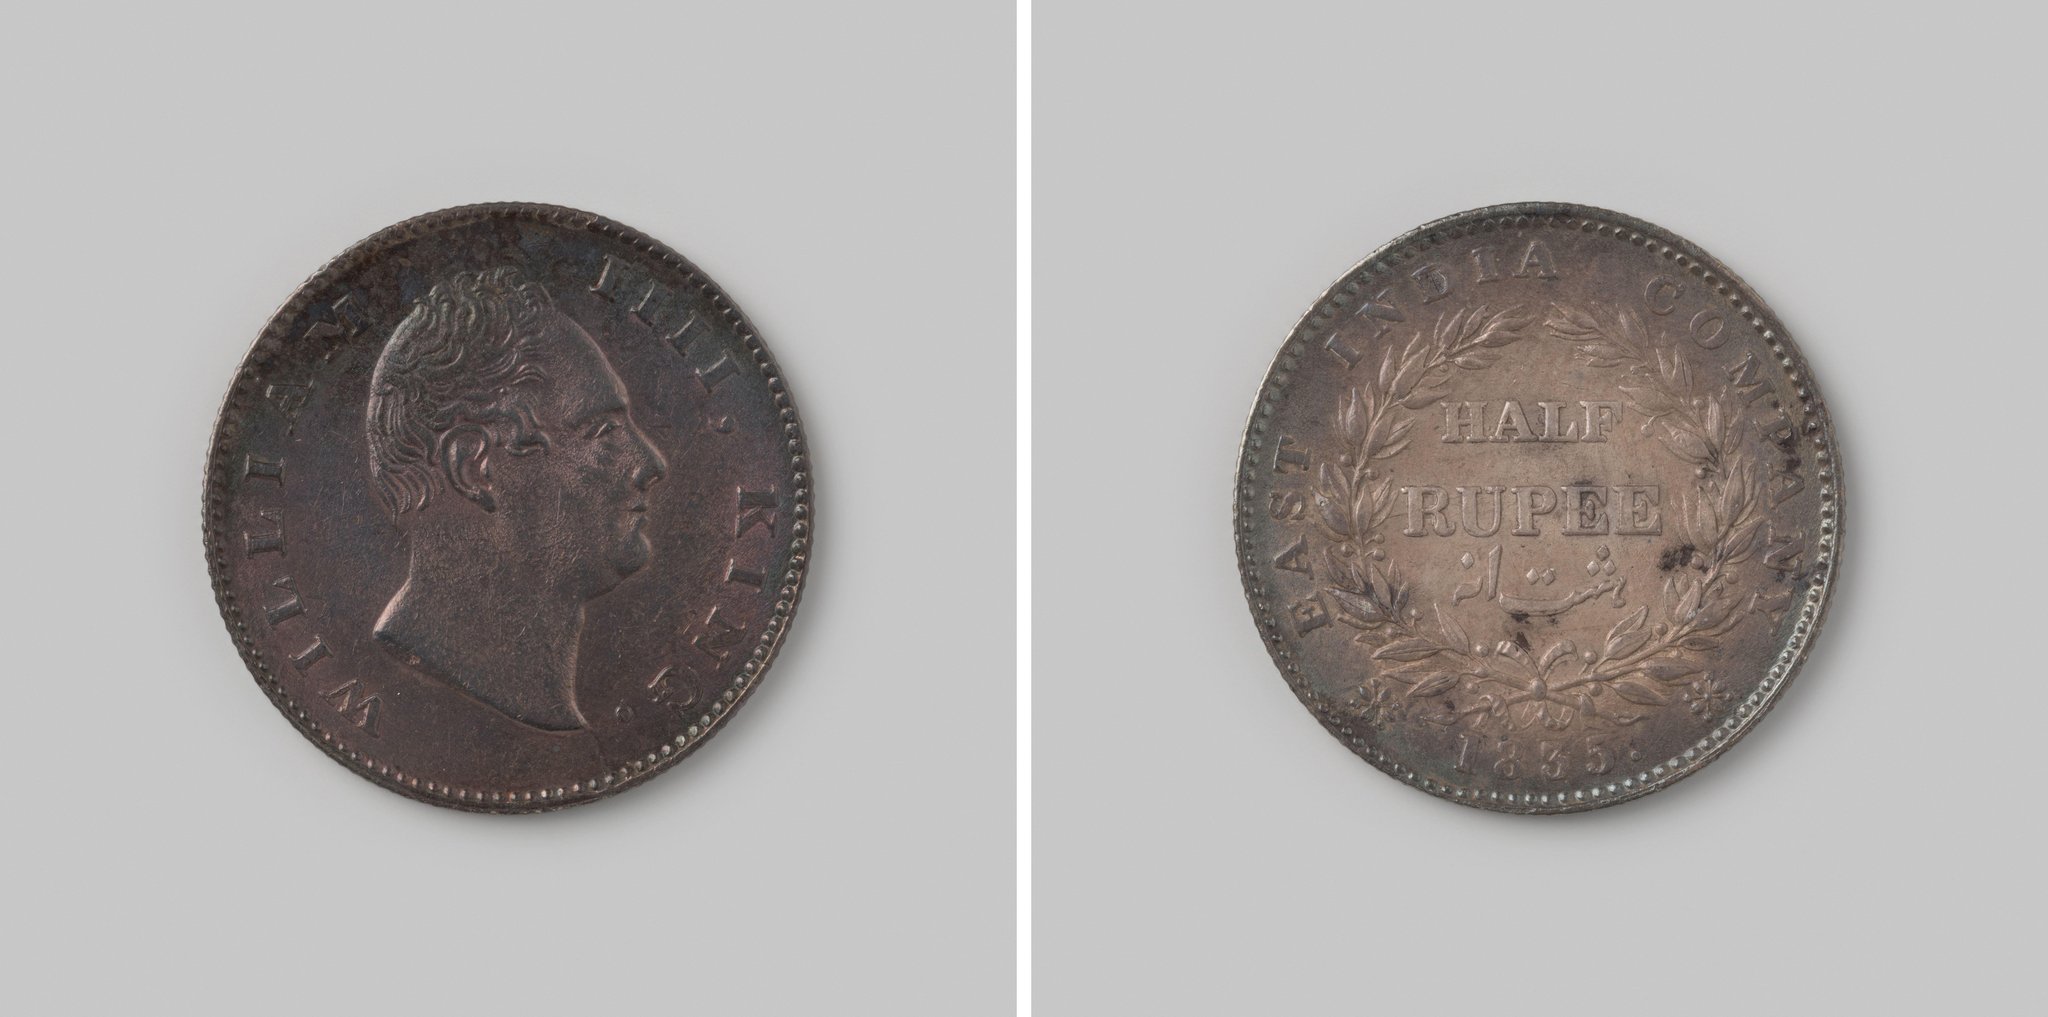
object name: coin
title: India, Engelse Oostindische Compagnie (EIC), op naam van koning William IV, ½ roepie, 1835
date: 1835-1840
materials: silver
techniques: striking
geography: kolkata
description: Zilveren munt. Voorzijde: hoofd van koning William IV naar rechts. Op halsafsnede inwendige letter F [= Forbes, muntmeester te Calcutta]. Keerzijde: tussen twee samengebonden takken in twee regels waarde-aanduiding: half rupee, waaronder in Arabische lettertekens in een regel waarde-aanduiding. Onderaan jaartal. Kartelrand.